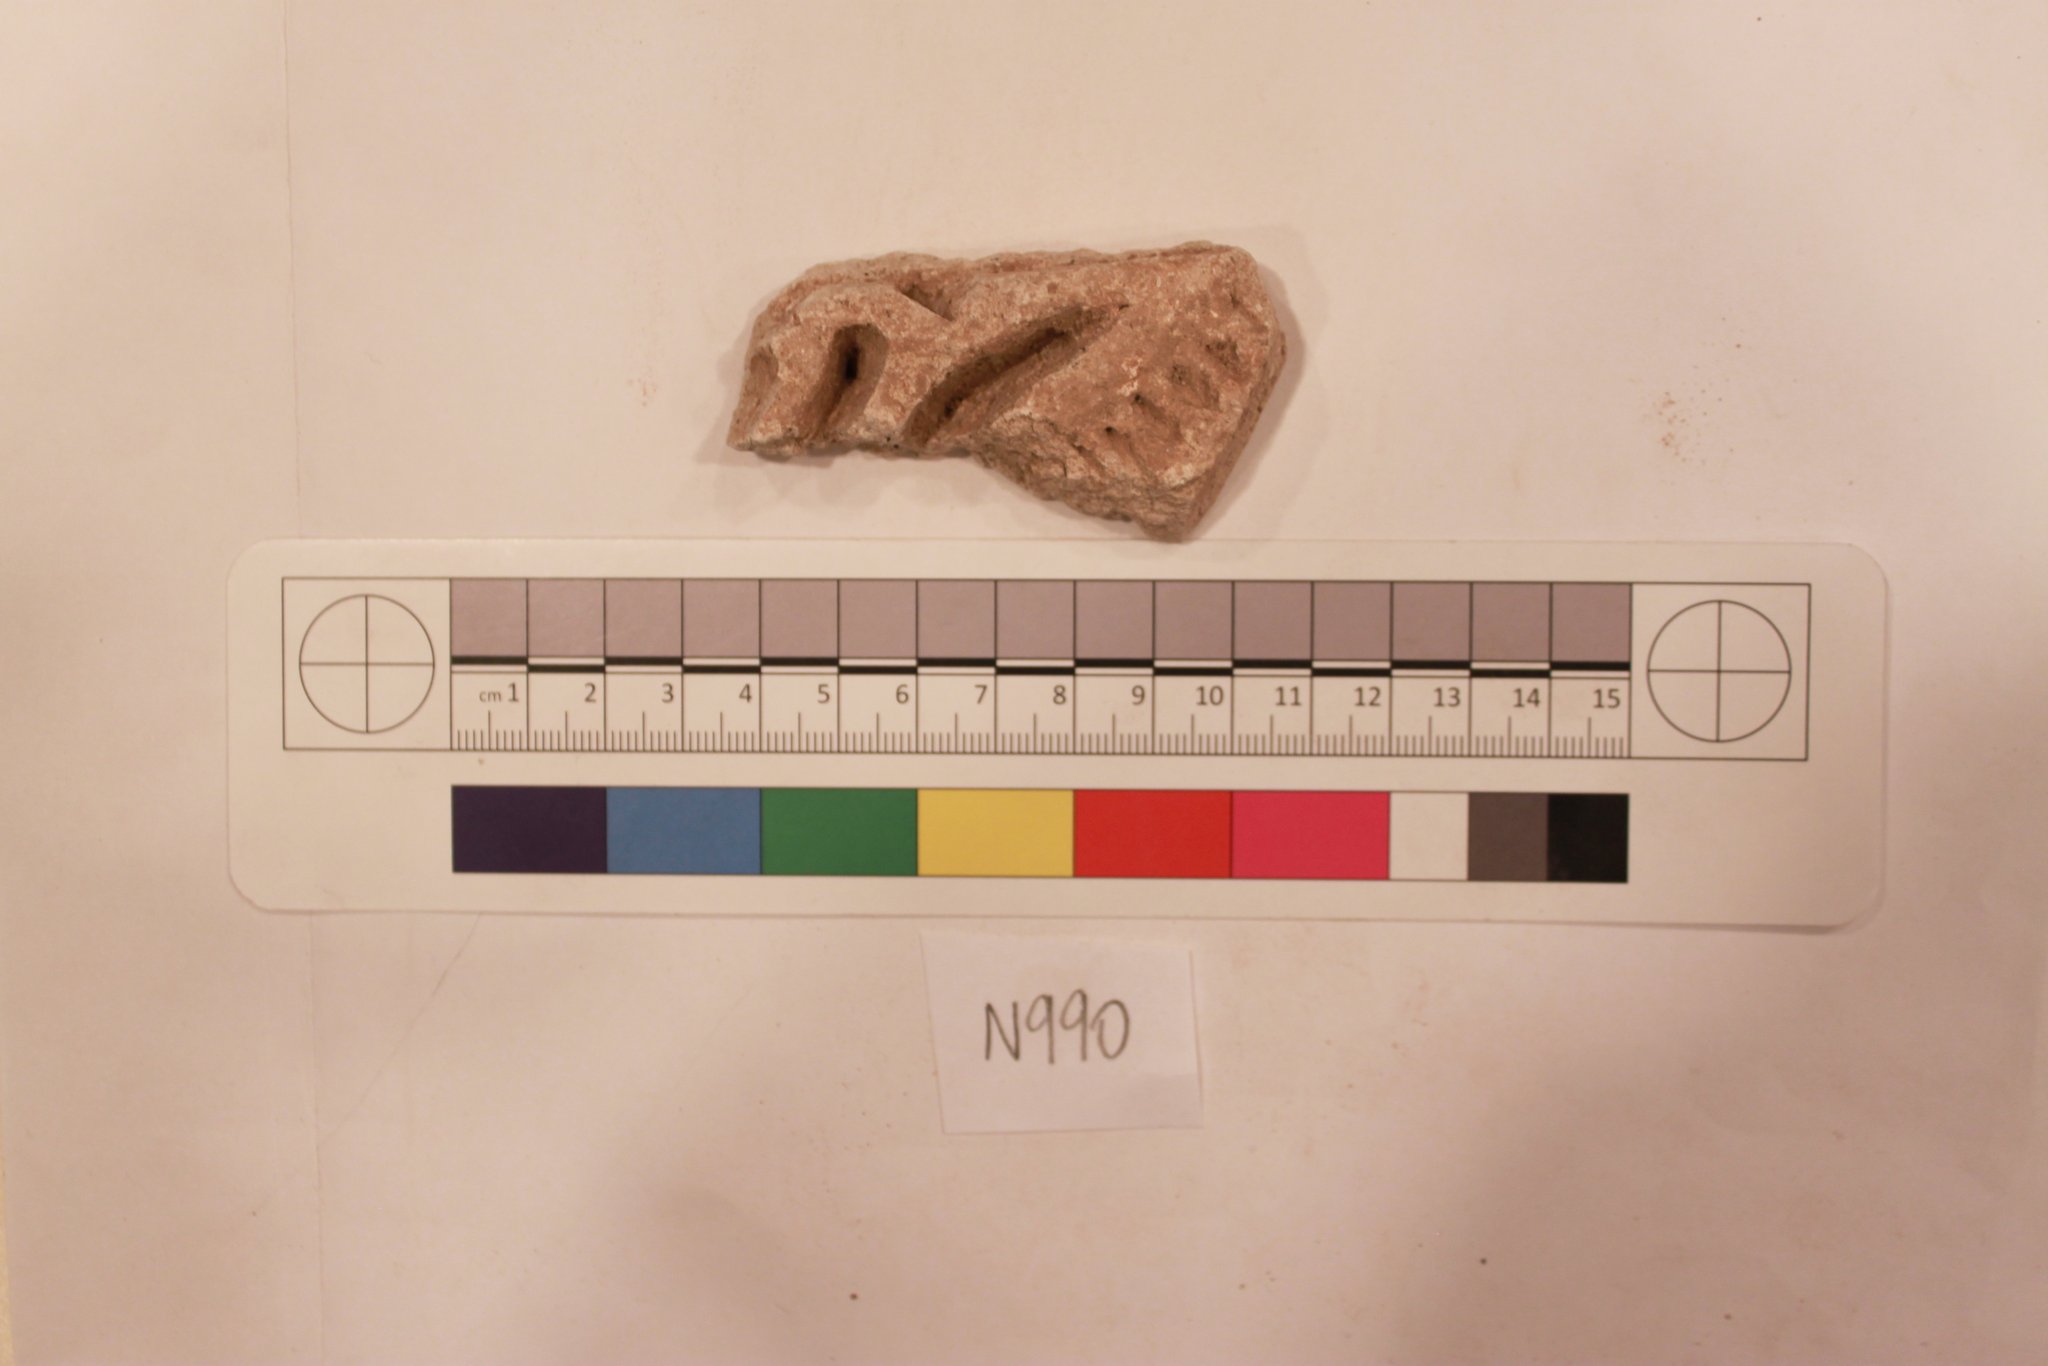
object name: fragment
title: Stucco Fragment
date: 701-1200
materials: plaster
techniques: carving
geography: iran